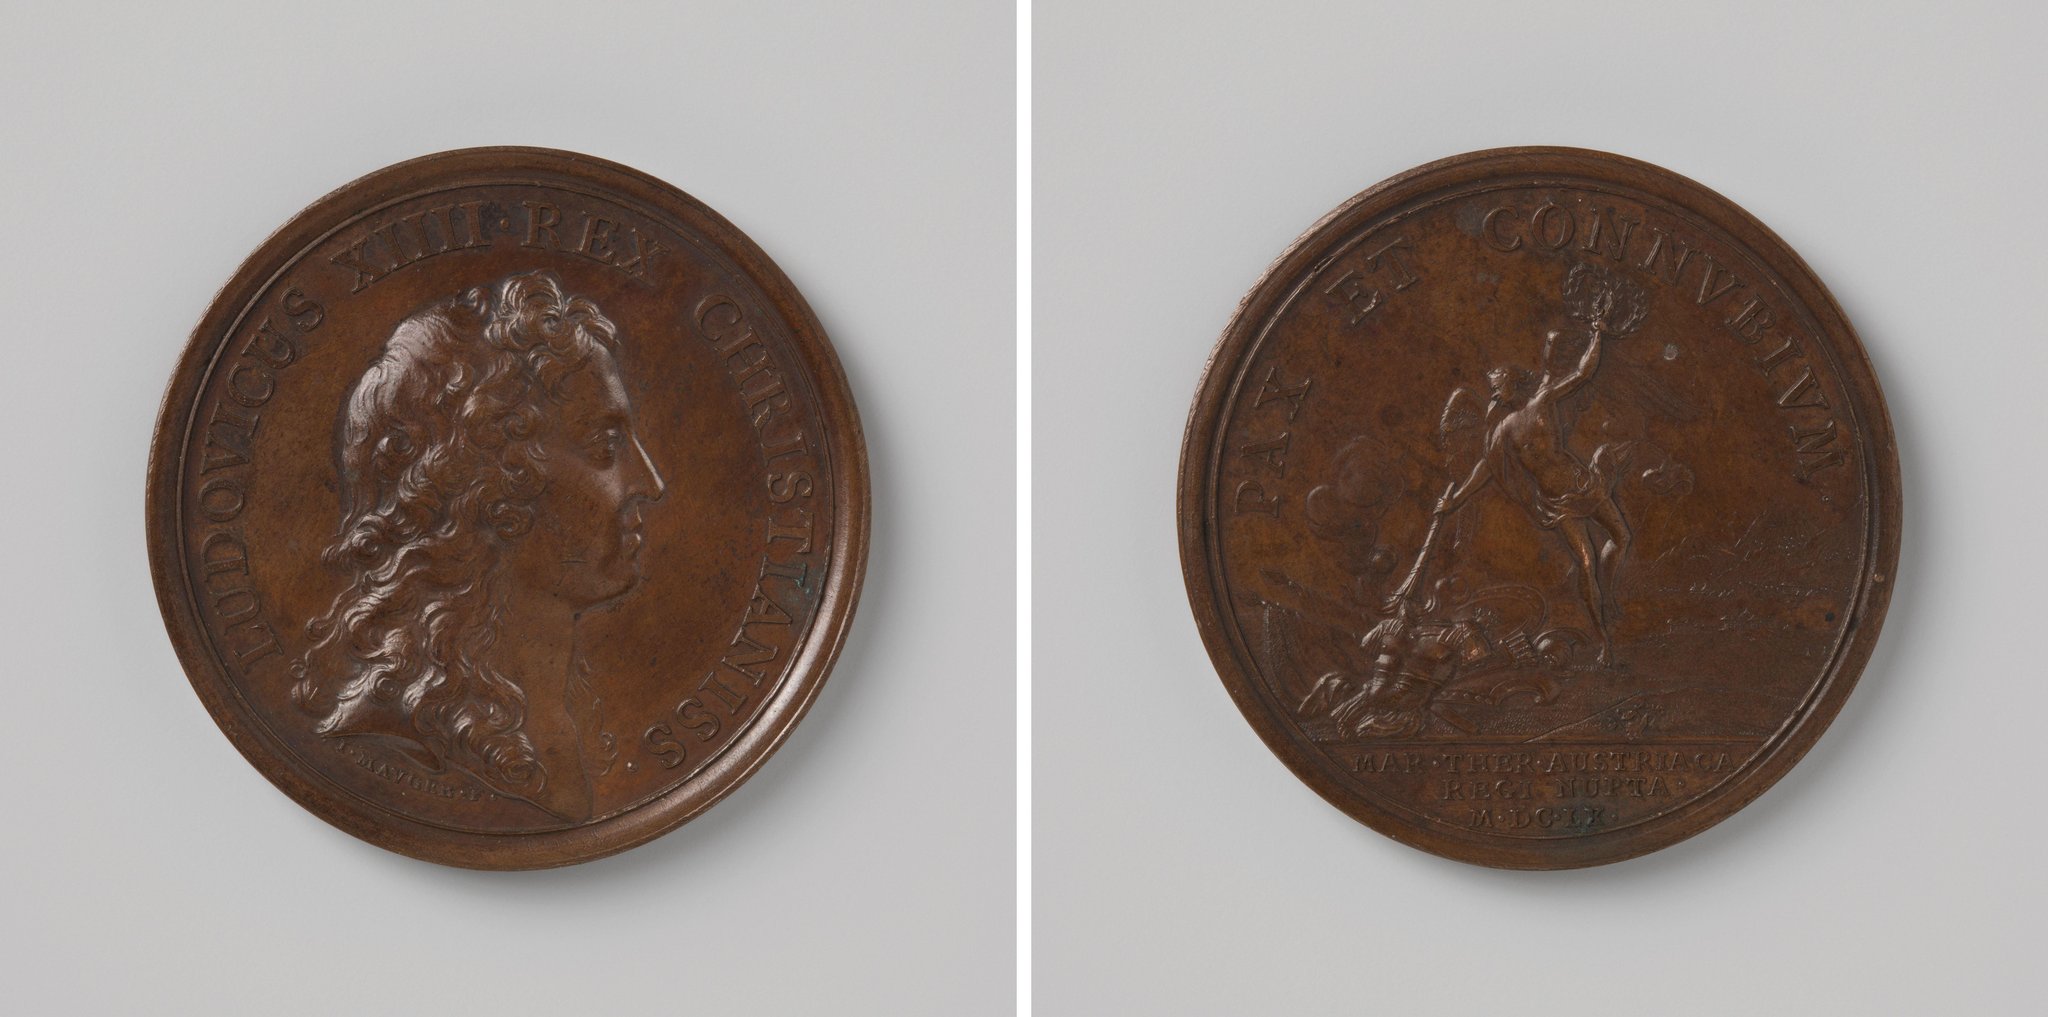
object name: history medal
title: Huwelijk van Lodewijk XIV met Maria Theresia van Oostenrijk en vrede van de Pyreneen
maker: jean mauger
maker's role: medailleur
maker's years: 1648-1722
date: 1699-1703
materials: bronze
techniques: striking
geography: paris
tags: lodewijk xiv (koning van frankrijk), maria theresia (koningin van frankrijk), france, spain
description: Bronzen penning. Voorzijde: borststuk jongeman binnen omschrift. Keerzijde: gevleugelde Huwelijksgod met twee myrtekransen en huwelijkstoorts waarmee hij wapentuig aansteekt binnen omschrift; afsnede: opschrift